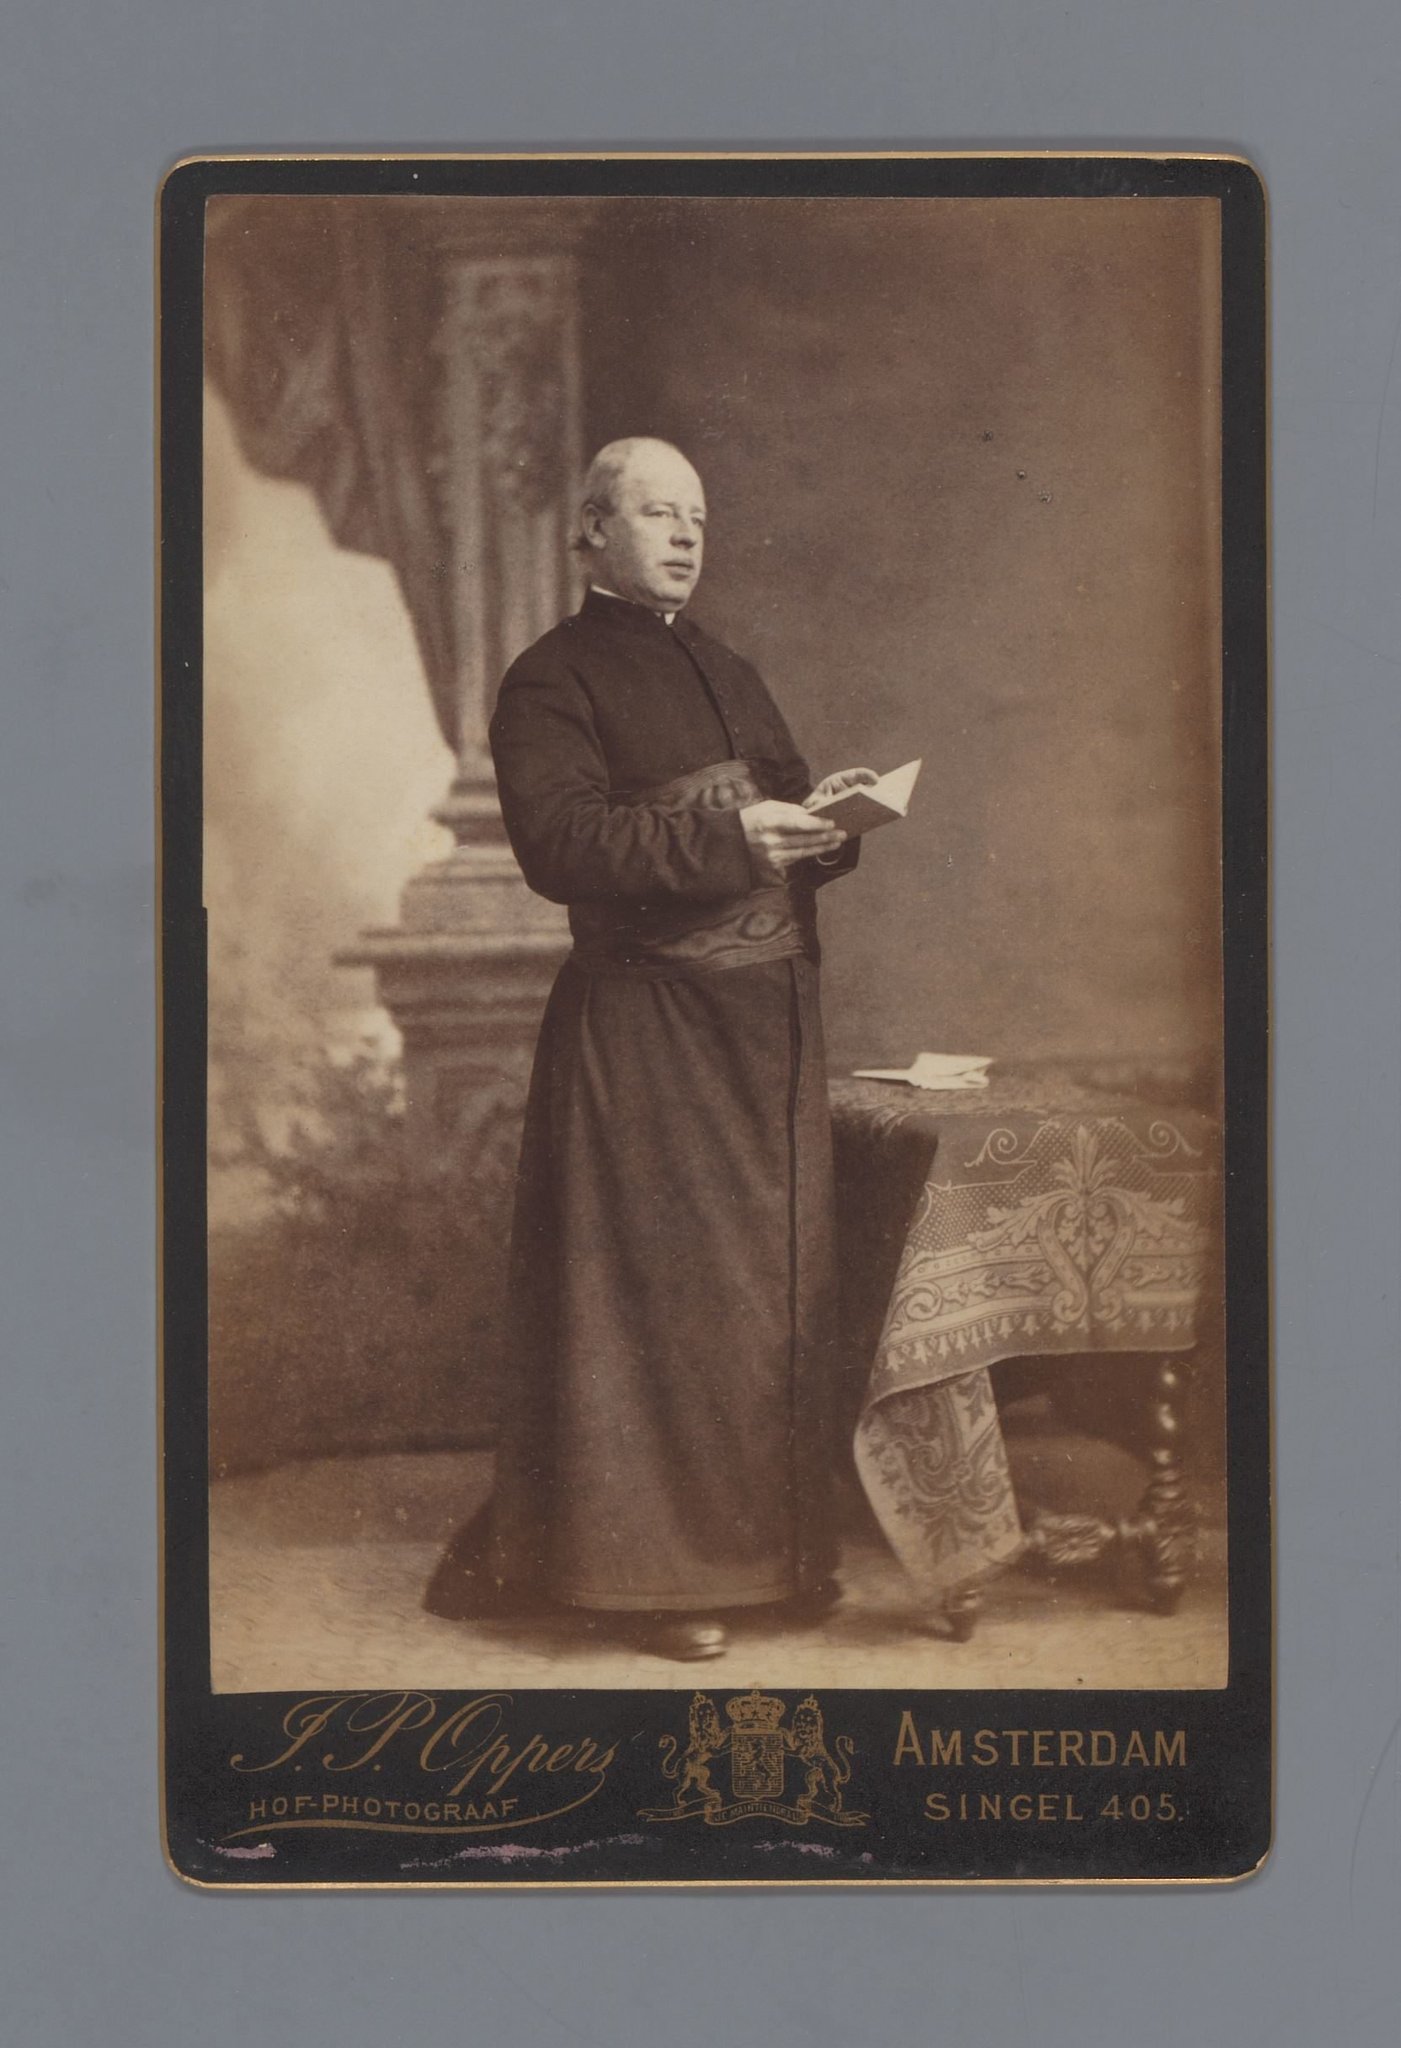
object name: cabinet photograph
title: Studioportret van een geestelijke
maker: johannes petrus oppers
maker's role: fotograaf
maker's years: 1833-1890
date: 1875-1900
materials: cardboard, photographic support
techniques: albumen print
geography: amsterdam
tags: organization, functionaries and dignitaries in roman catholic church; clergy in general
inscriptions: name: ‘J. P. Oppers hof-photograaf Amsterdam Singel 405.’, inscription: ‘H. Sikkes opvolger van J. P. Oppers Singel 405, Amsterdam’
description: RP-F-F18956 is een ander exemplaar van dezelfde foto.